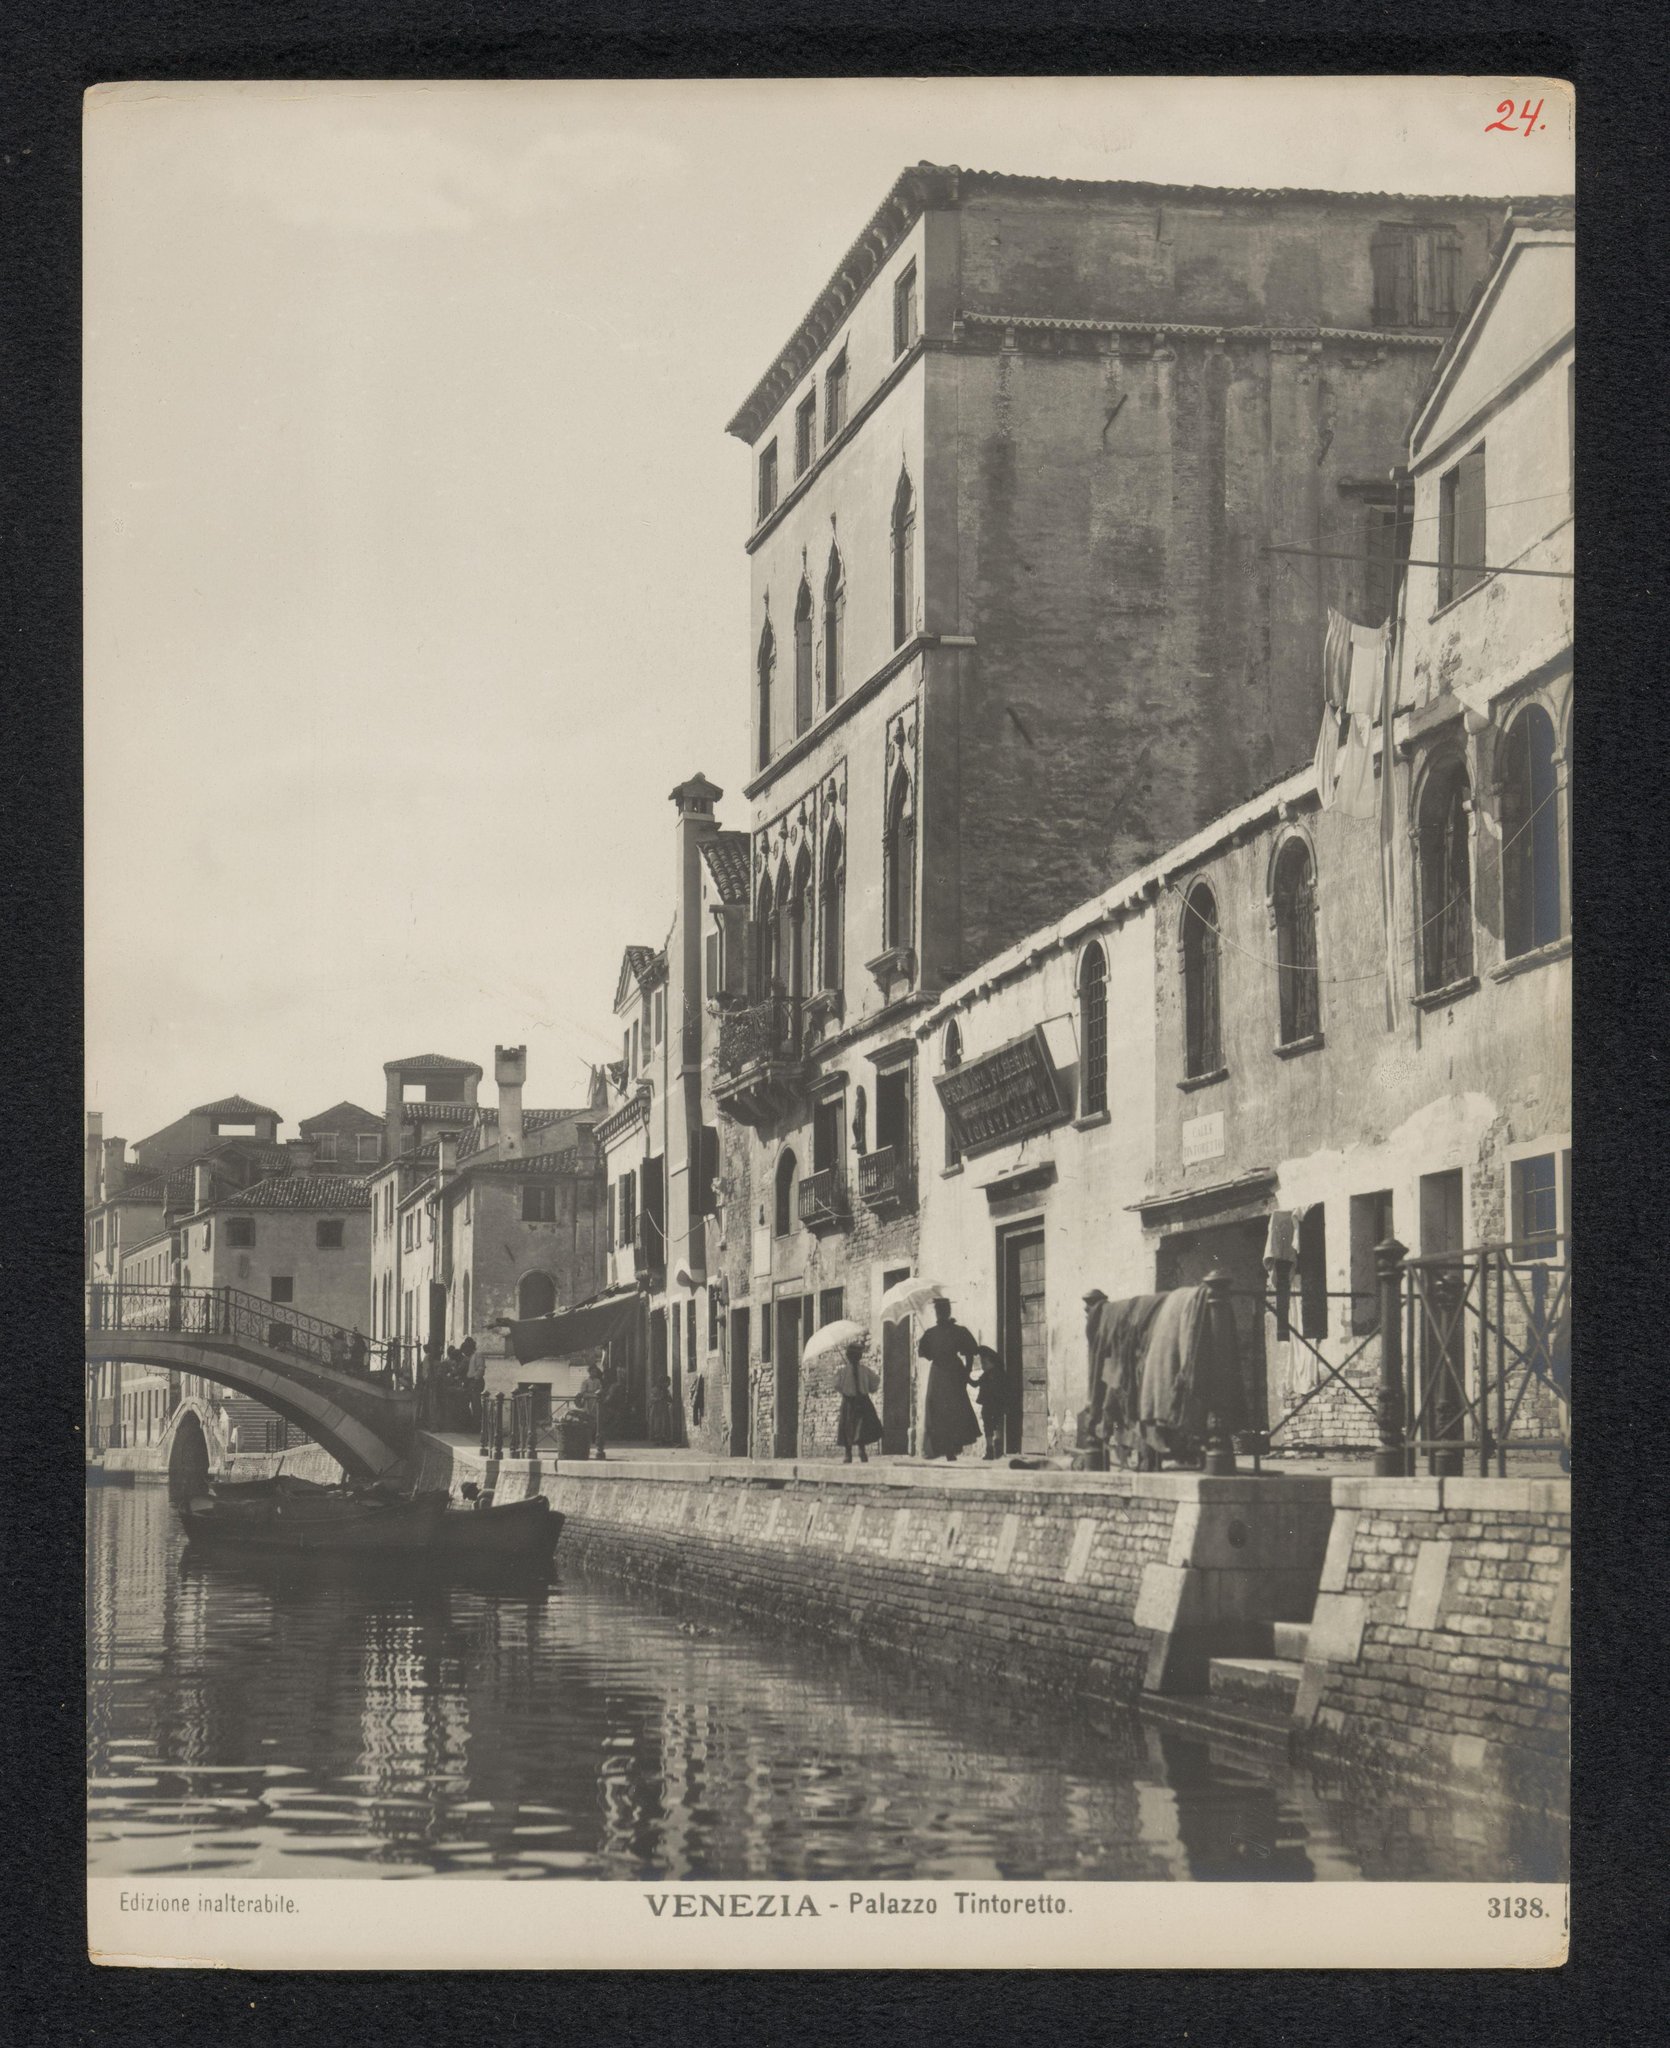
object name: photograph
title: Exterieur van het woonhuis van Tintoretto te Venetië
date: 1900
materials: cardboard, photographic support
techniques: gelatin silver print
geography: venice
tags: canal, housing, façade (of house or building), gondola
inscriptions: number: ‘24.’, inscription: ‘Rijksnormaalschool voor Teekenonderwijzers Amsterdam’, number: ‘3138.’